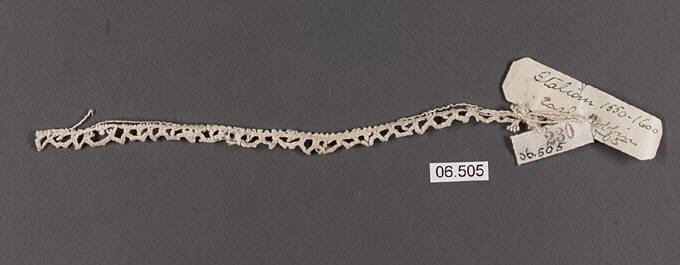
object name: fragment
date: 1550-1600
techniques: lace